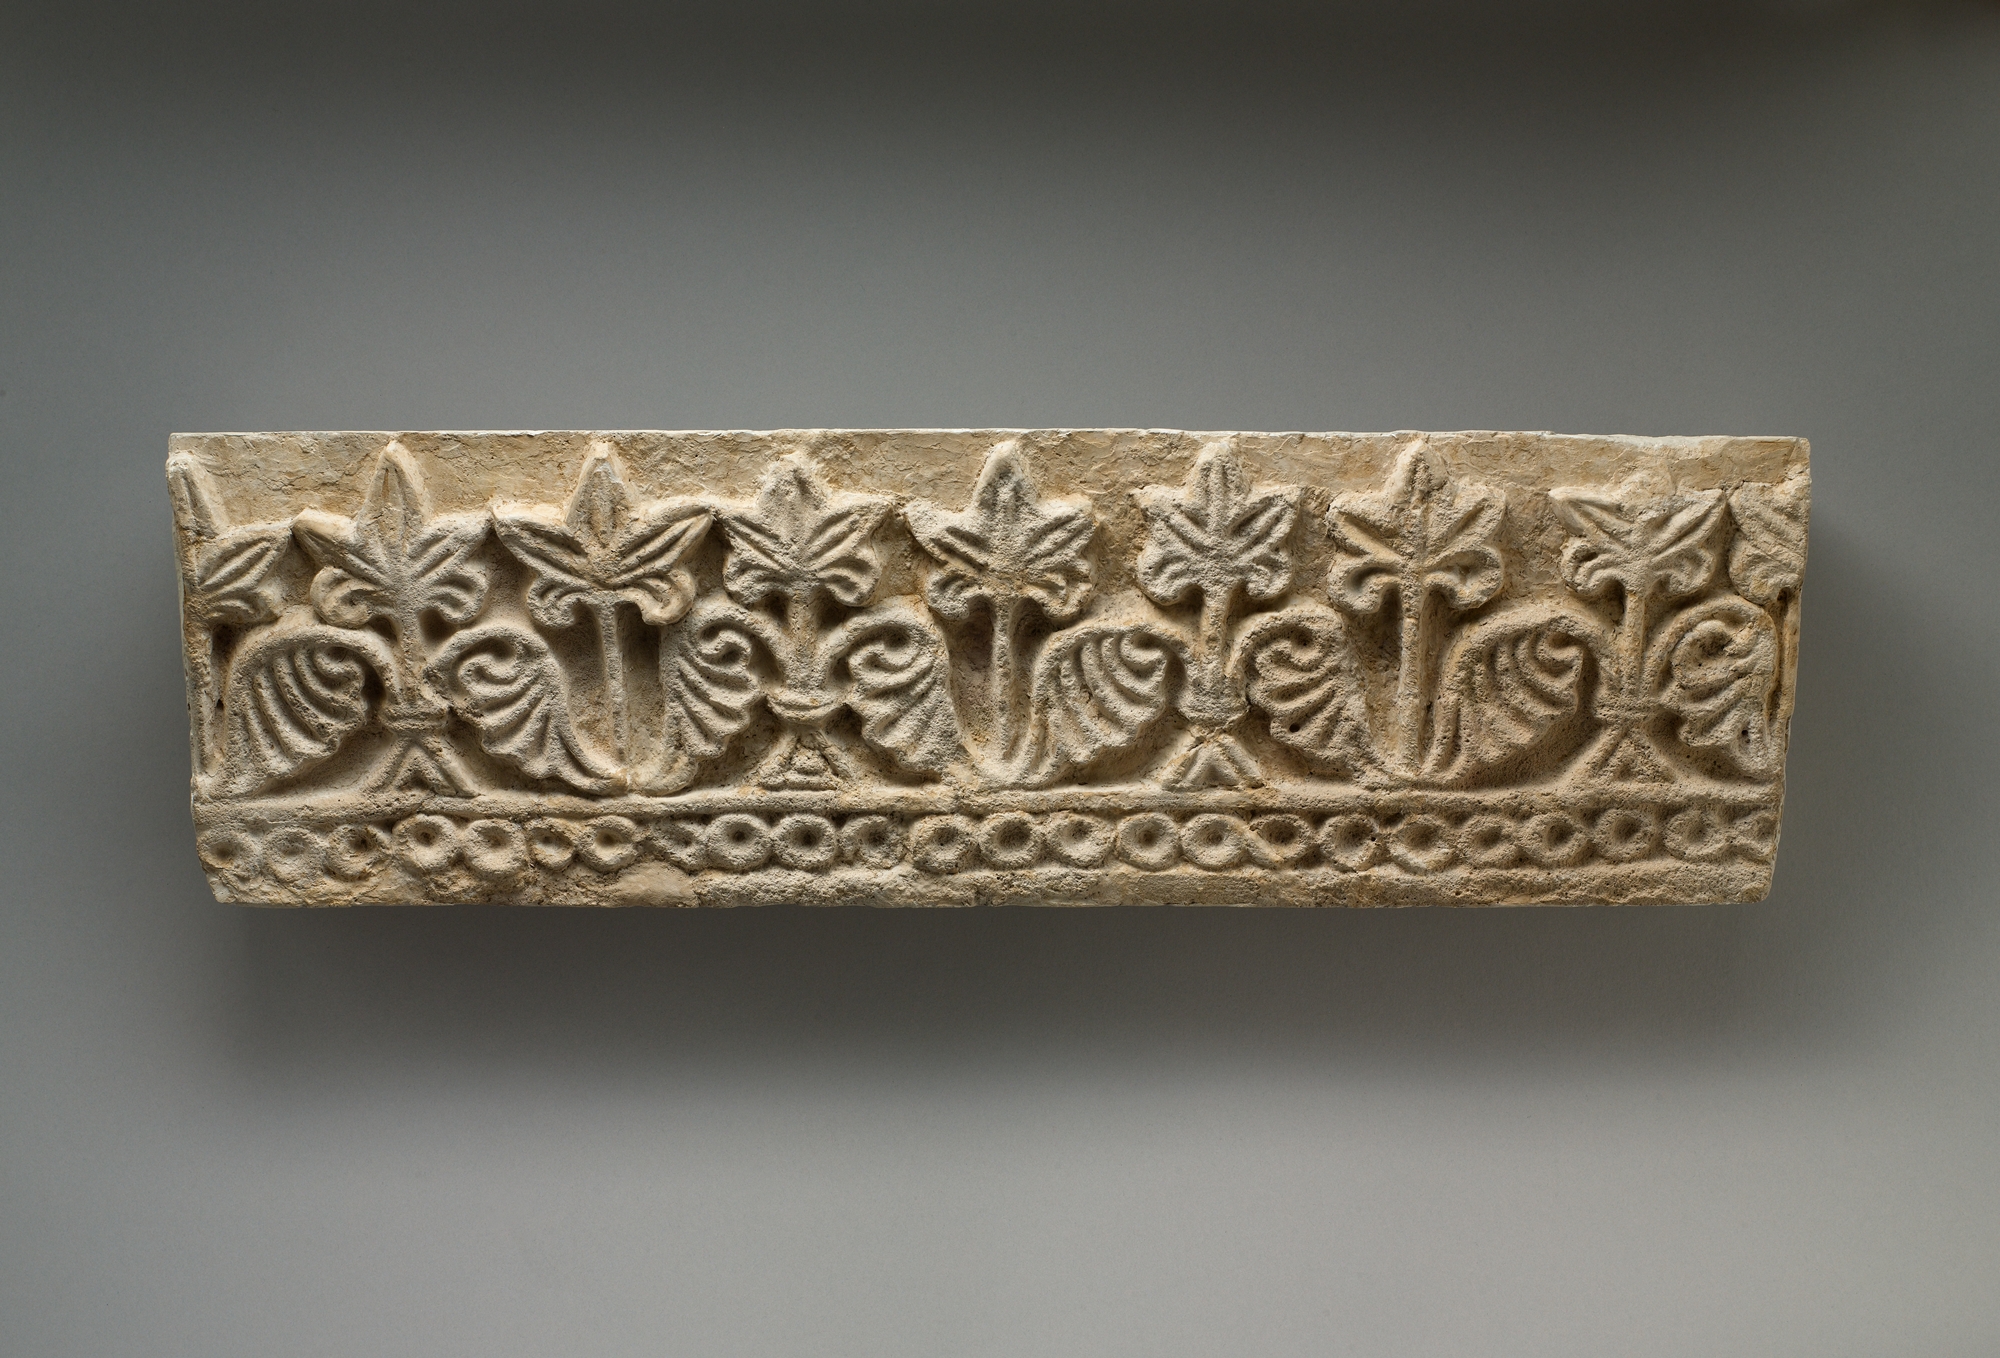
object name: relief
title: Wall decoration with vegetal and geometric design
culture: sasanian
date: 501-600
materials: plaster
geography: mesopotamia